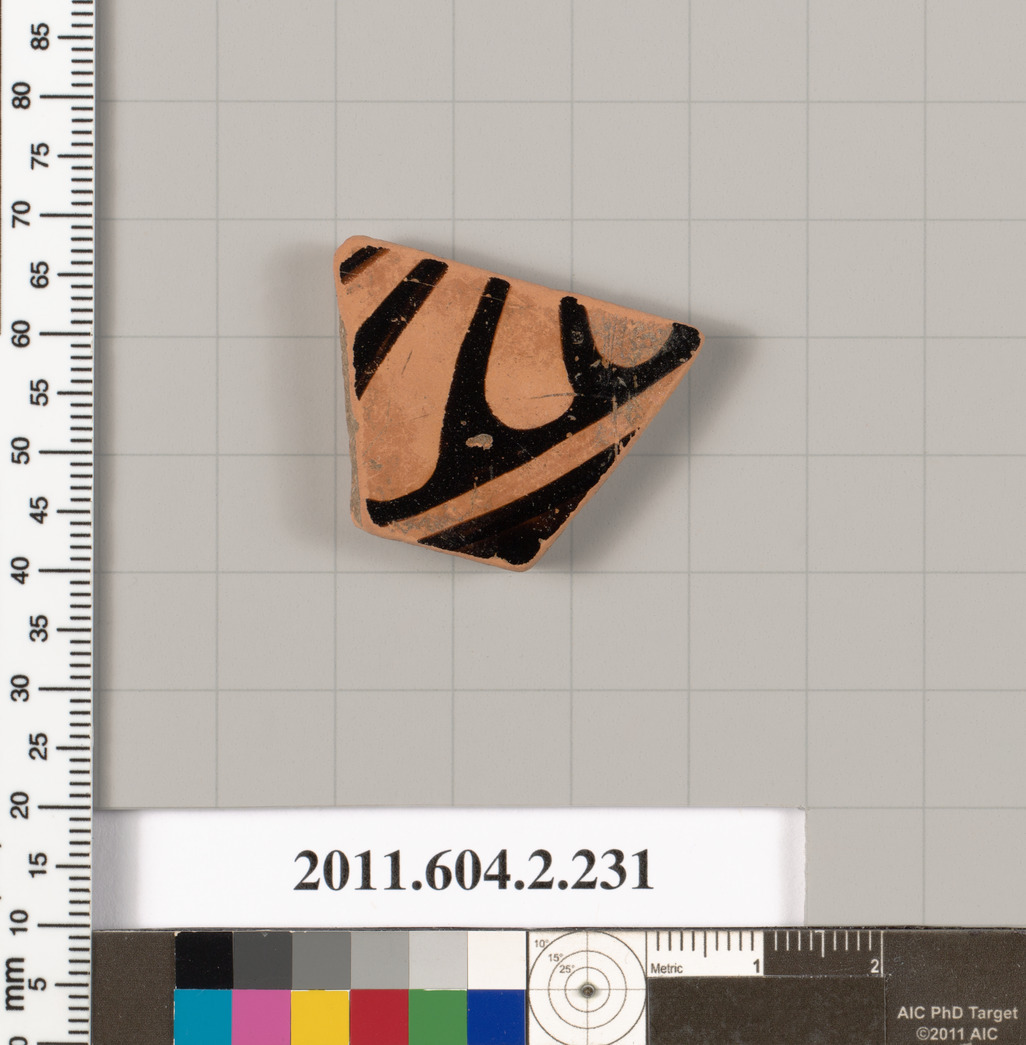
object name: stamnos fragment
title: Terracotta fragment of a stamnos (jar)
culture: greek, attic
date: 470-450 BCE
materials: terracotta